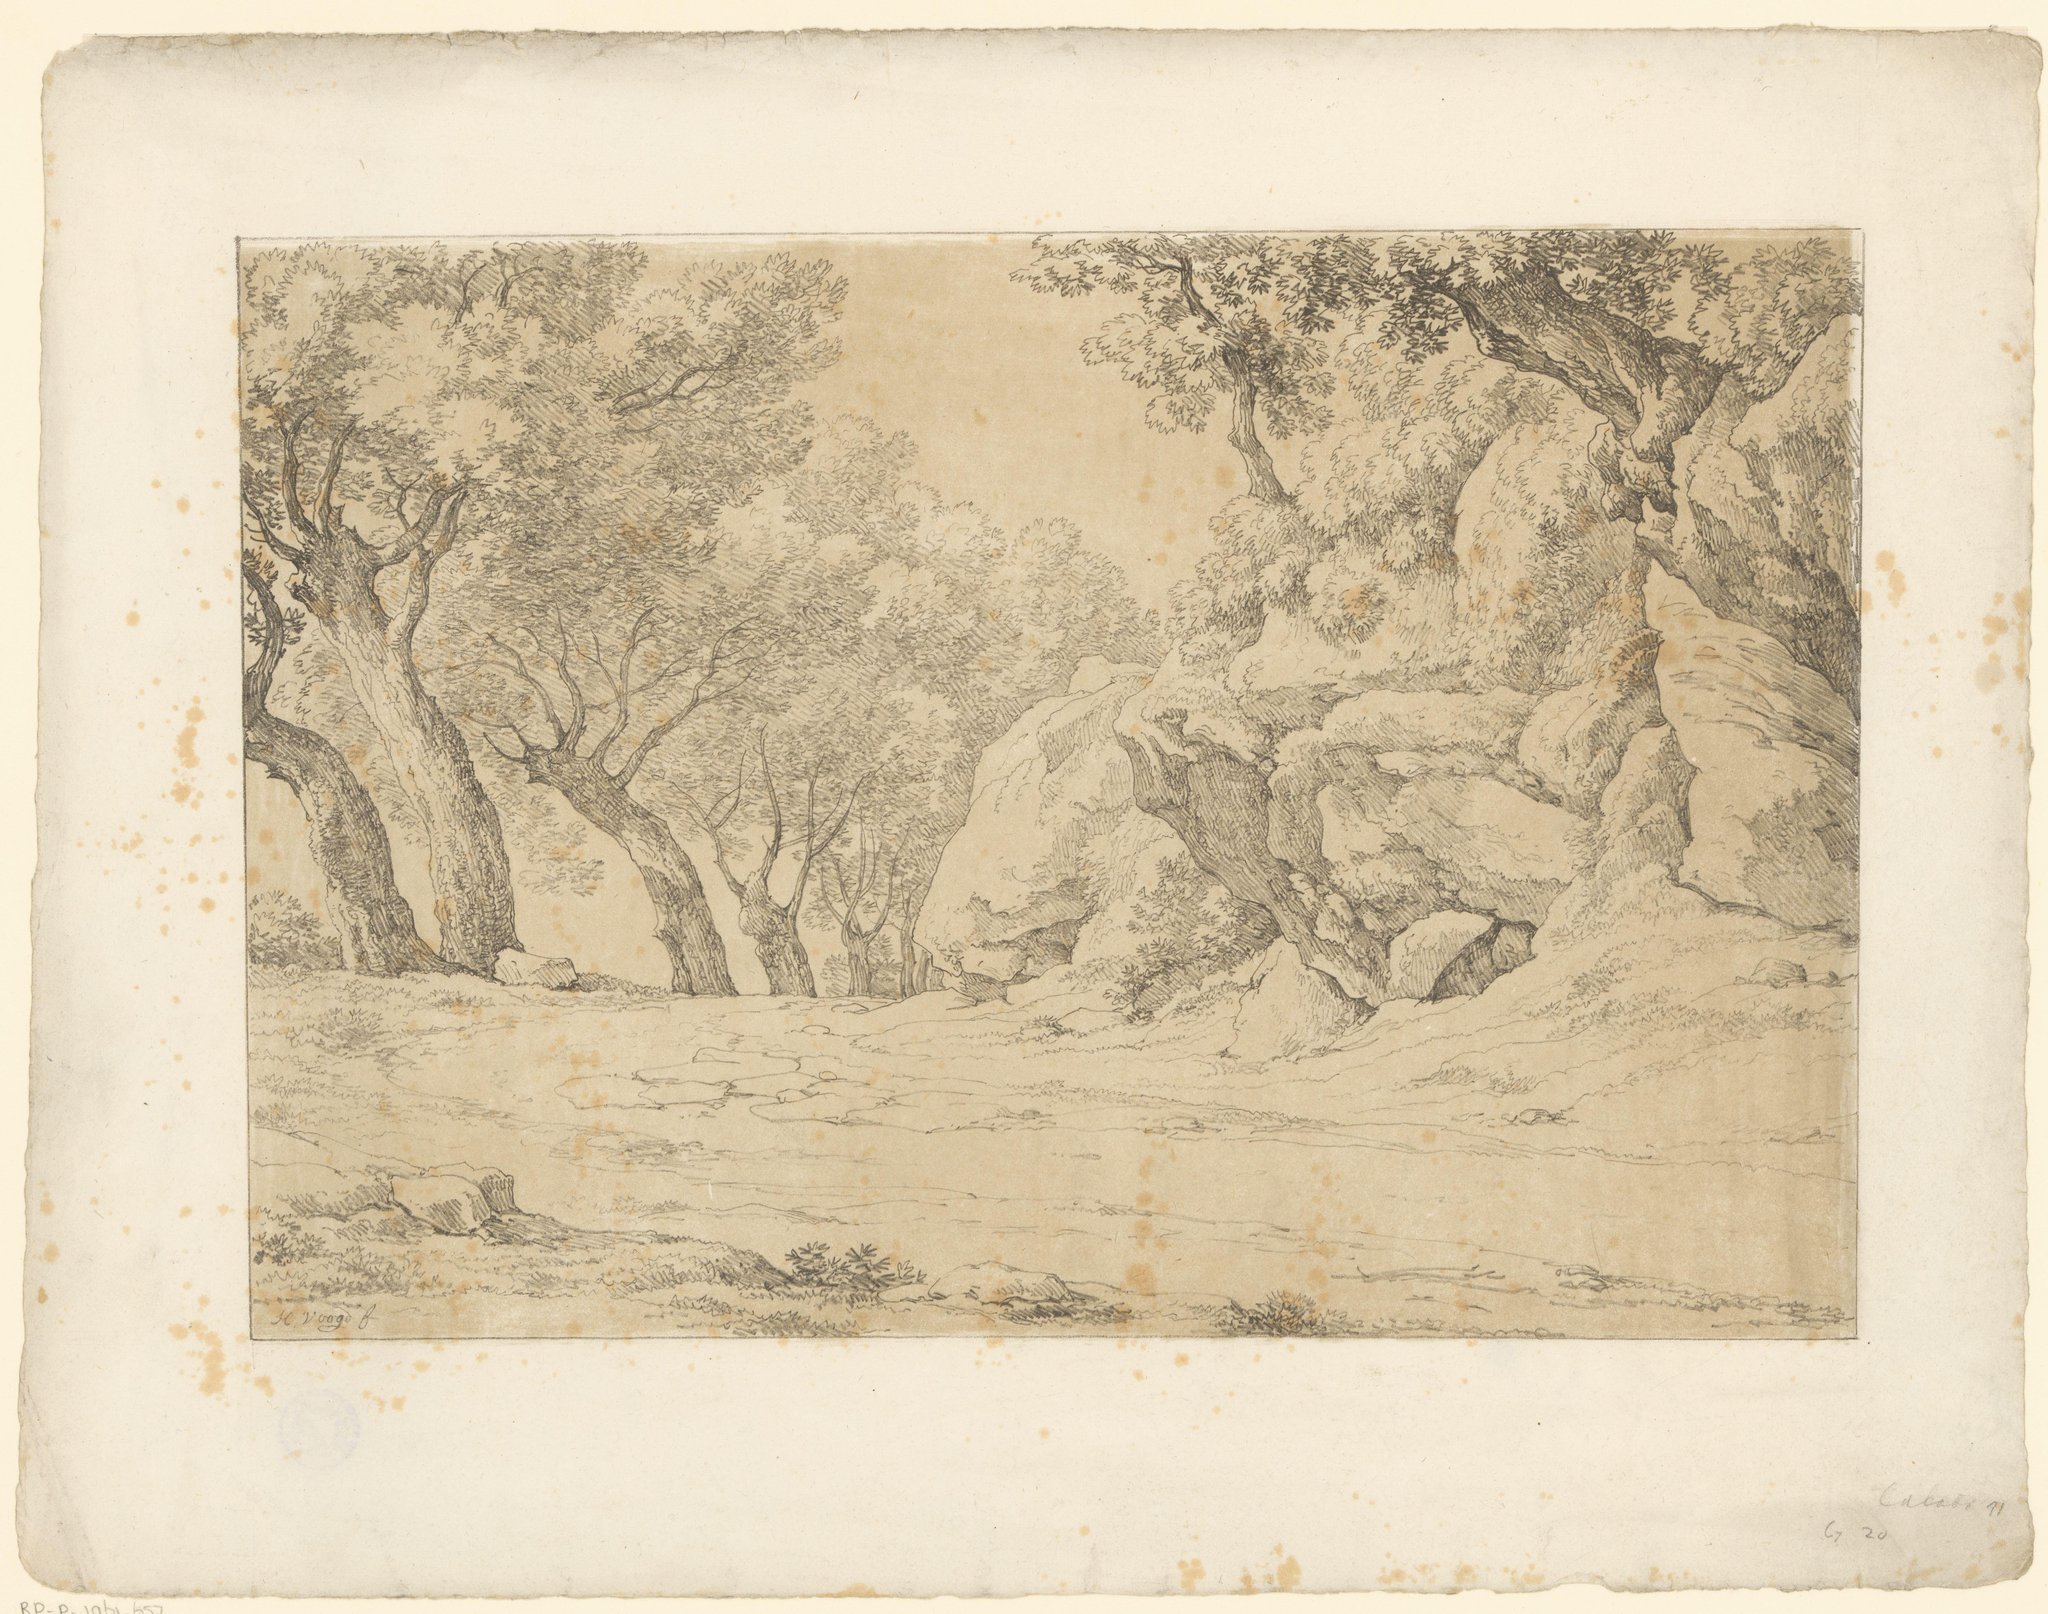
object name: print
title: Italiaanse landschappen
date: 1820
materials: paper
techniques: tone lithography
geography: rome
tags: landscapes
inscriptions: collector's mark: Lugt 2228, stamp: ‘School voor de grafische vakken te Utrecht’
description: Een laan met links bomen en rechts begroeide rotsen.